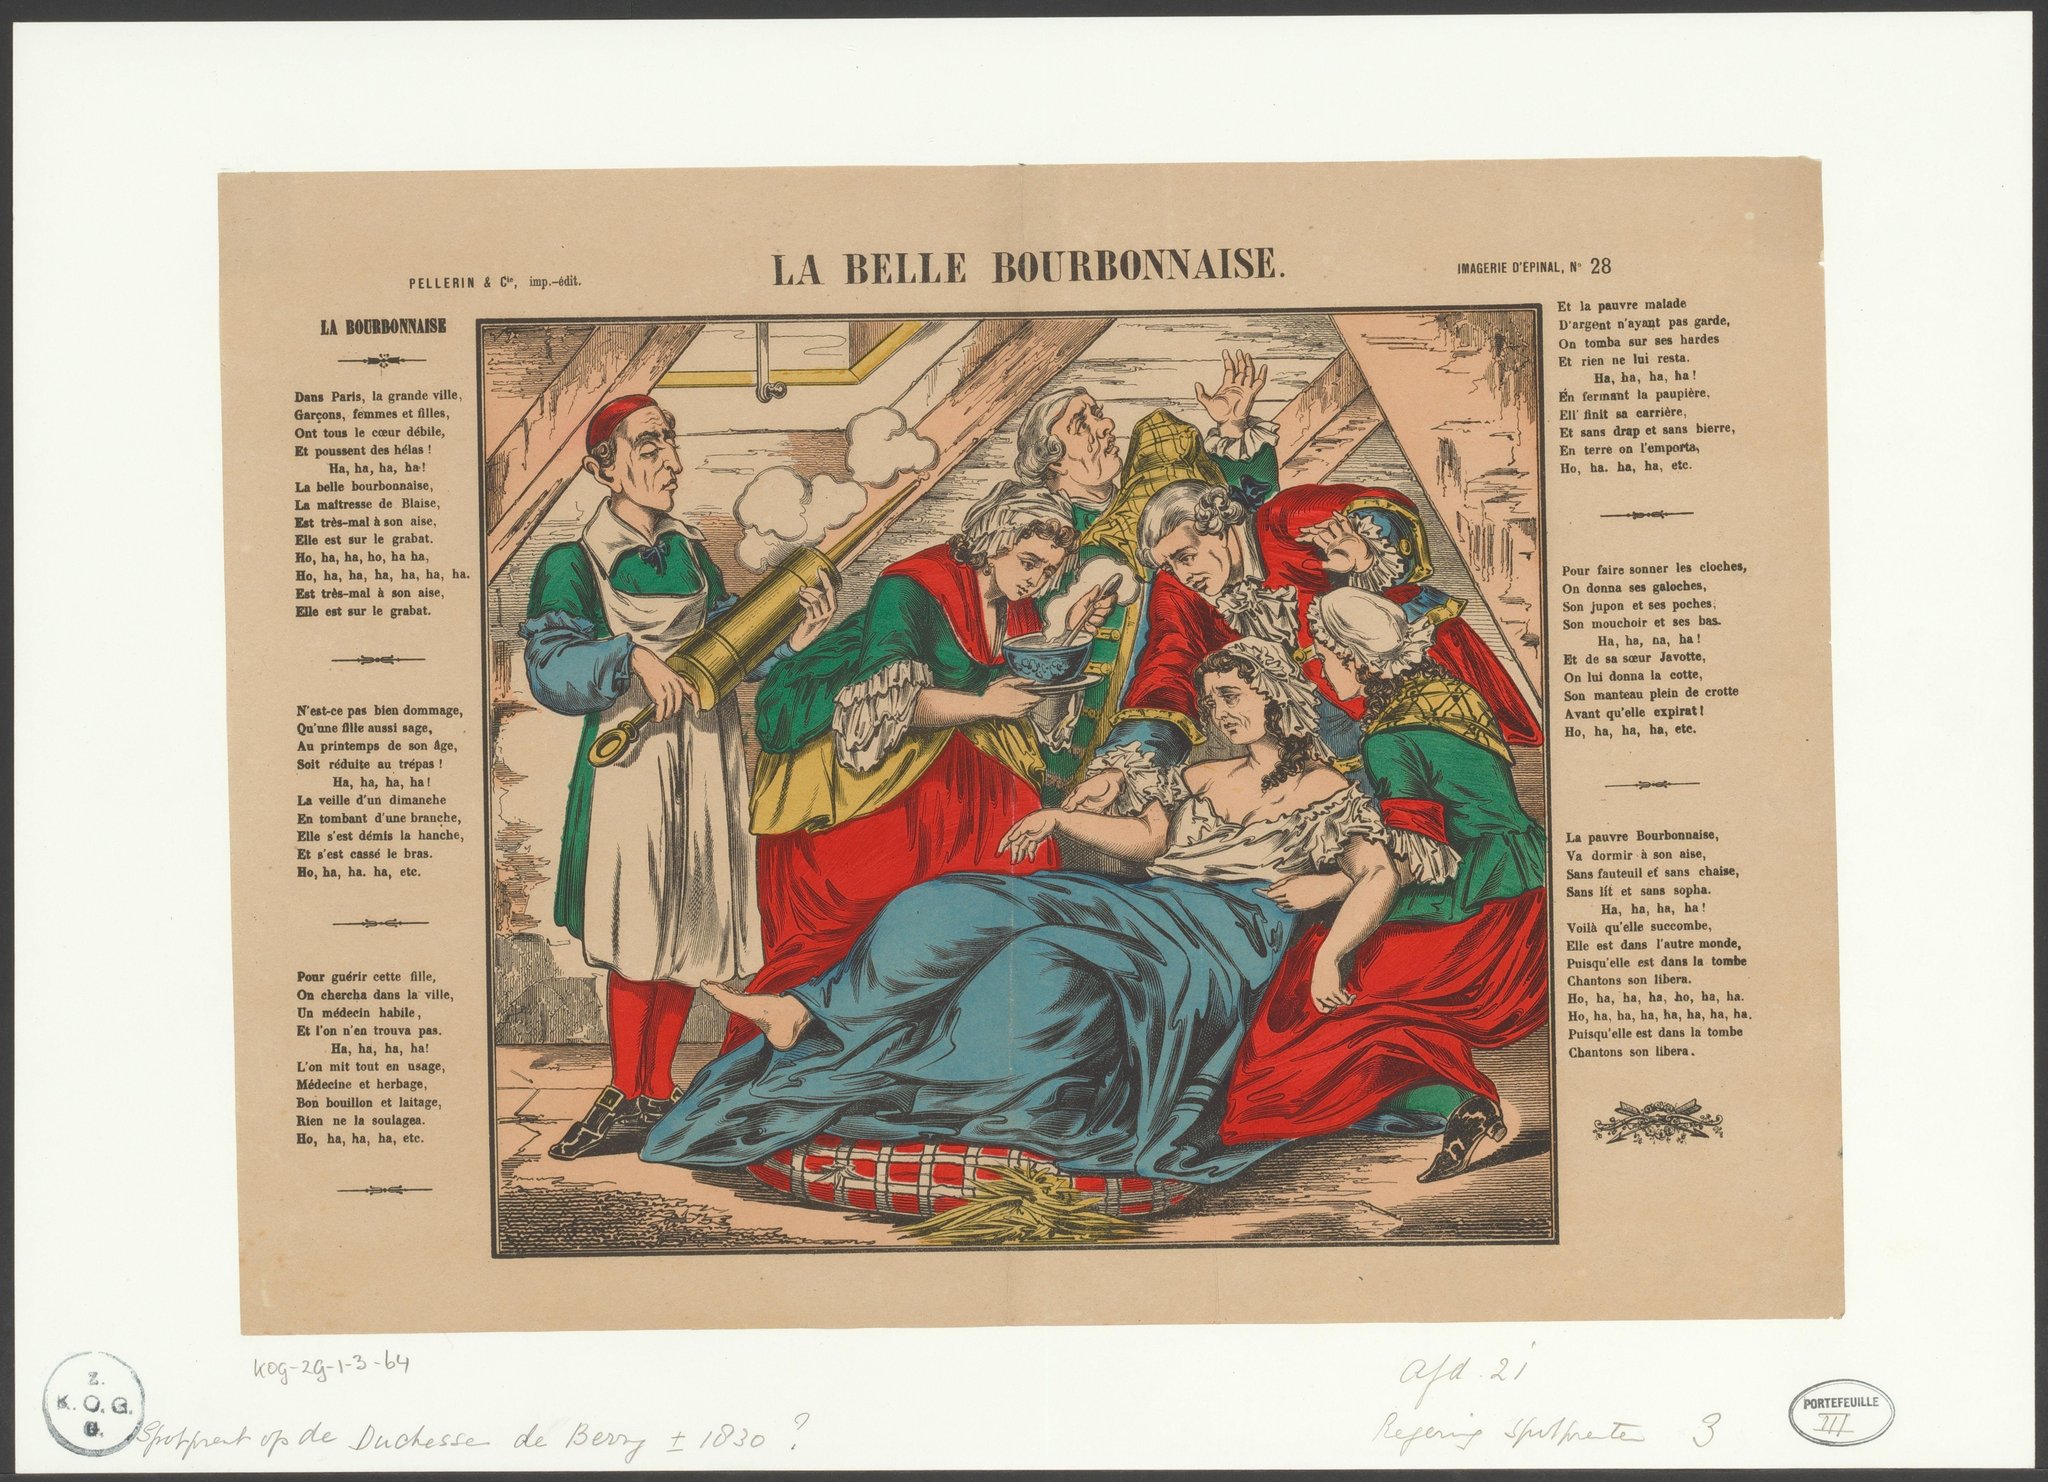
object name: cartoon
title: La belle Bourbonnaise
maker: Anonymous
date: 1798-1900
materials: paper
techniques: hand coloring, lithograph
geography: epinal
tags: nursing, tending the sick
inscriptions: stamp, collector's mark: Lugt 1641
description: Mogelijk een spotprent op Maria Carolina van Bourbon-Sicilië, ca. 1830. Aan de zijkanten de tekst van het lied La Belle Bourbonnaise. Rechtsboven genummerd: Imagerie d'épinal, no 28. Onderwerpsrubrieken binnen de Atlas Zeden en Gewoonten: Regeering, Spotprenten.